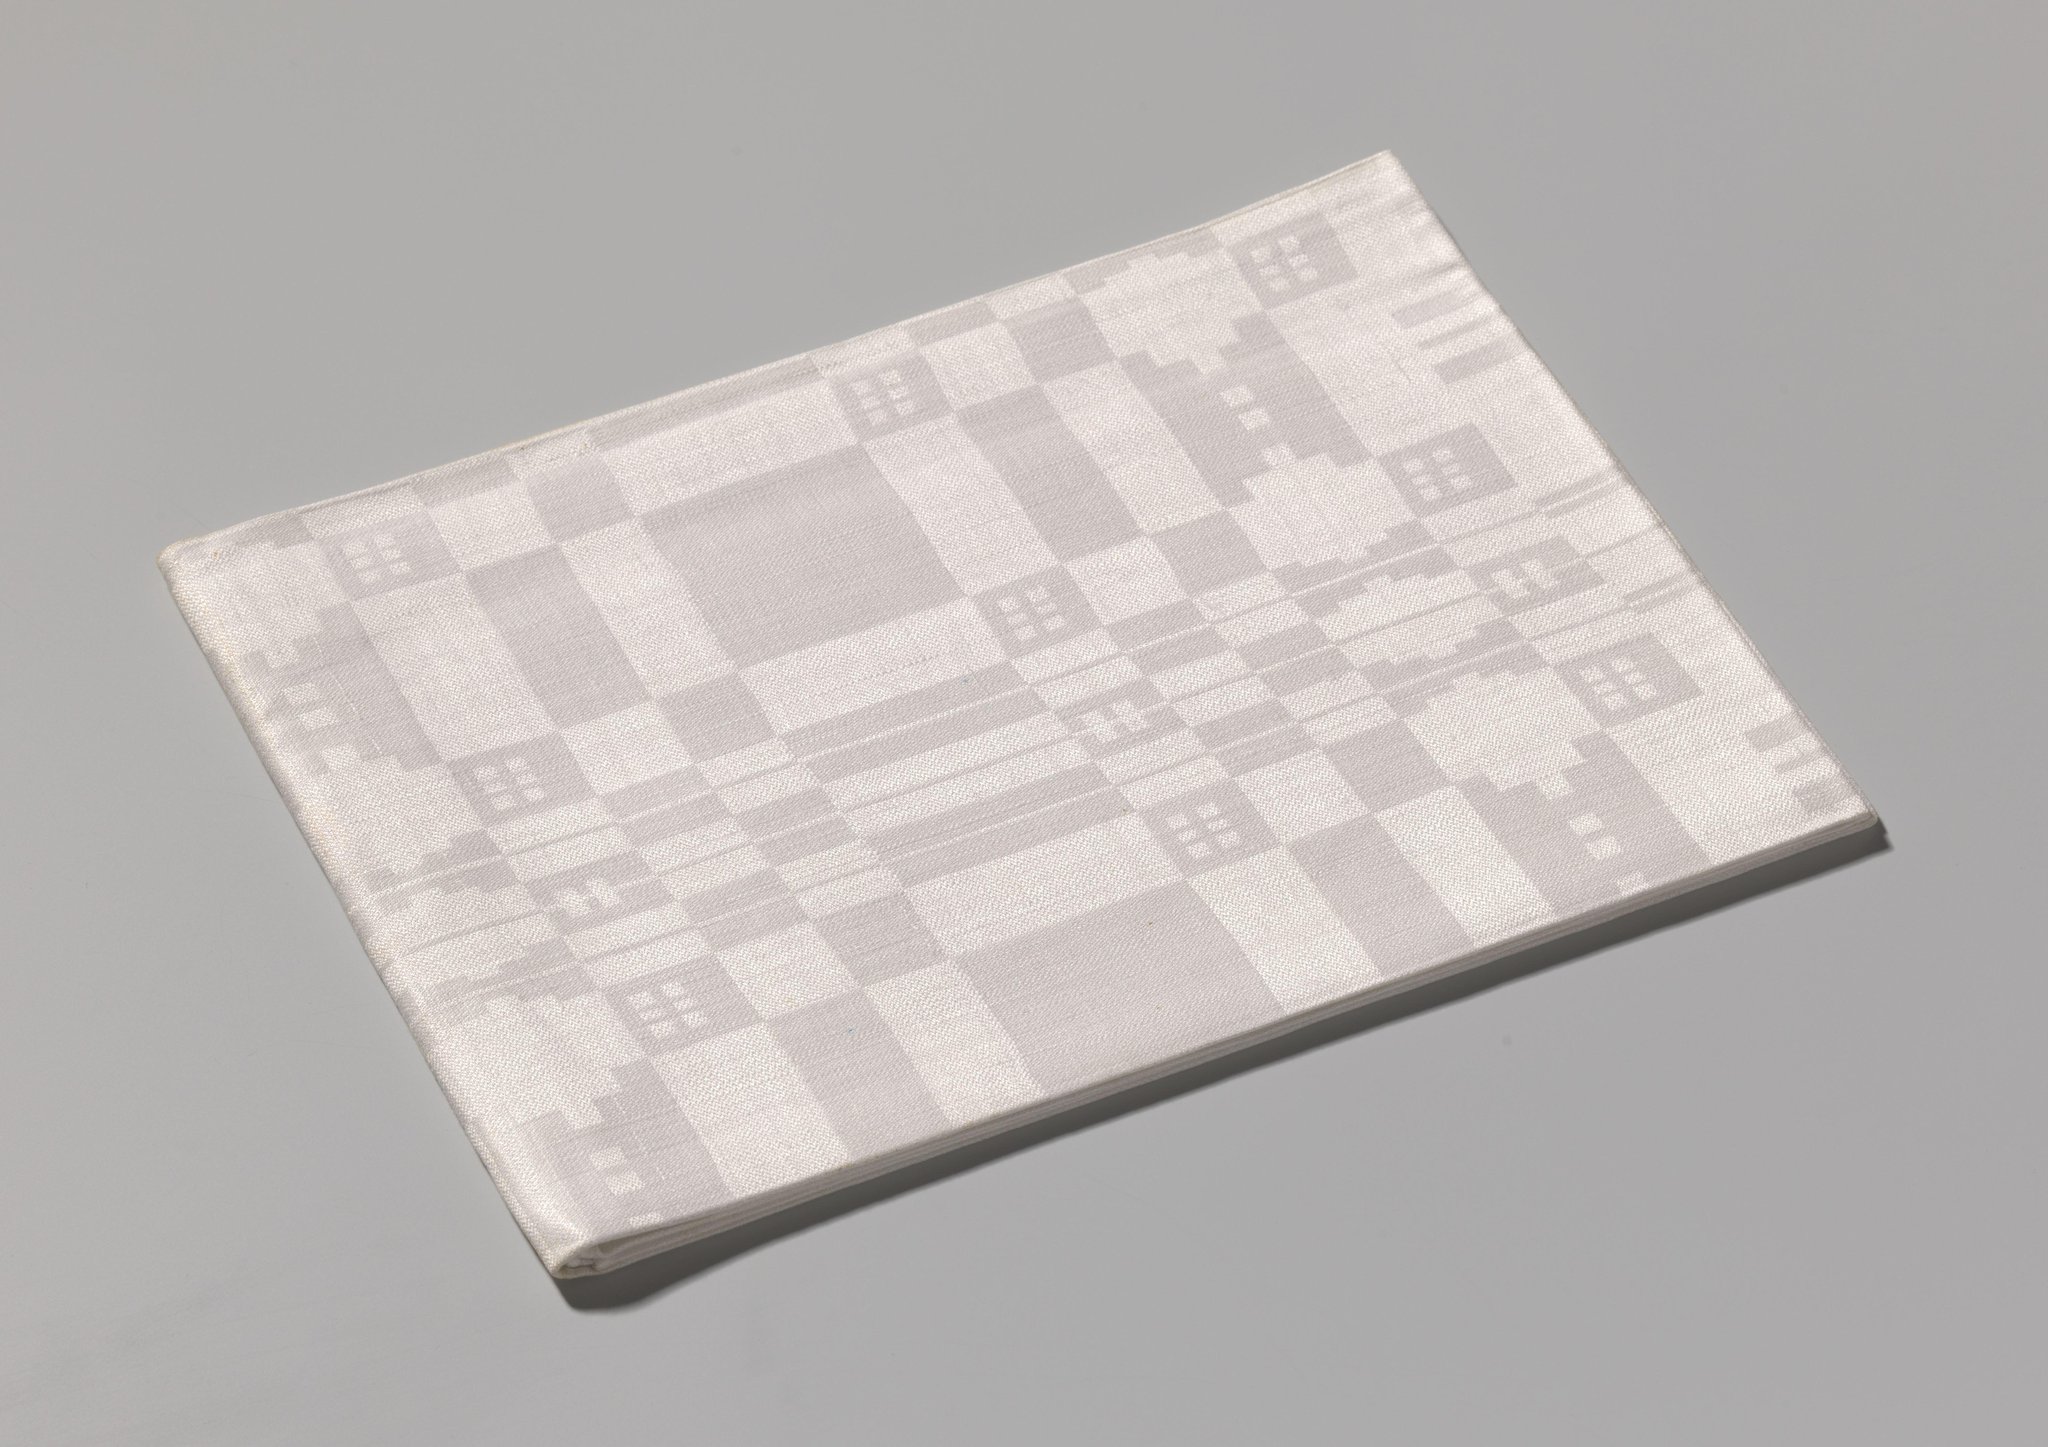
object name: napkin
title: Servet van linnen met pellenpatroon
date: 1742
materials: linen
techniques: peeled fabric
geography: northern netherlands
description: Wit linnendamasten servet met pellenpatroon, genaamd "Torenwerk". Merk kroon WG 44 1742.